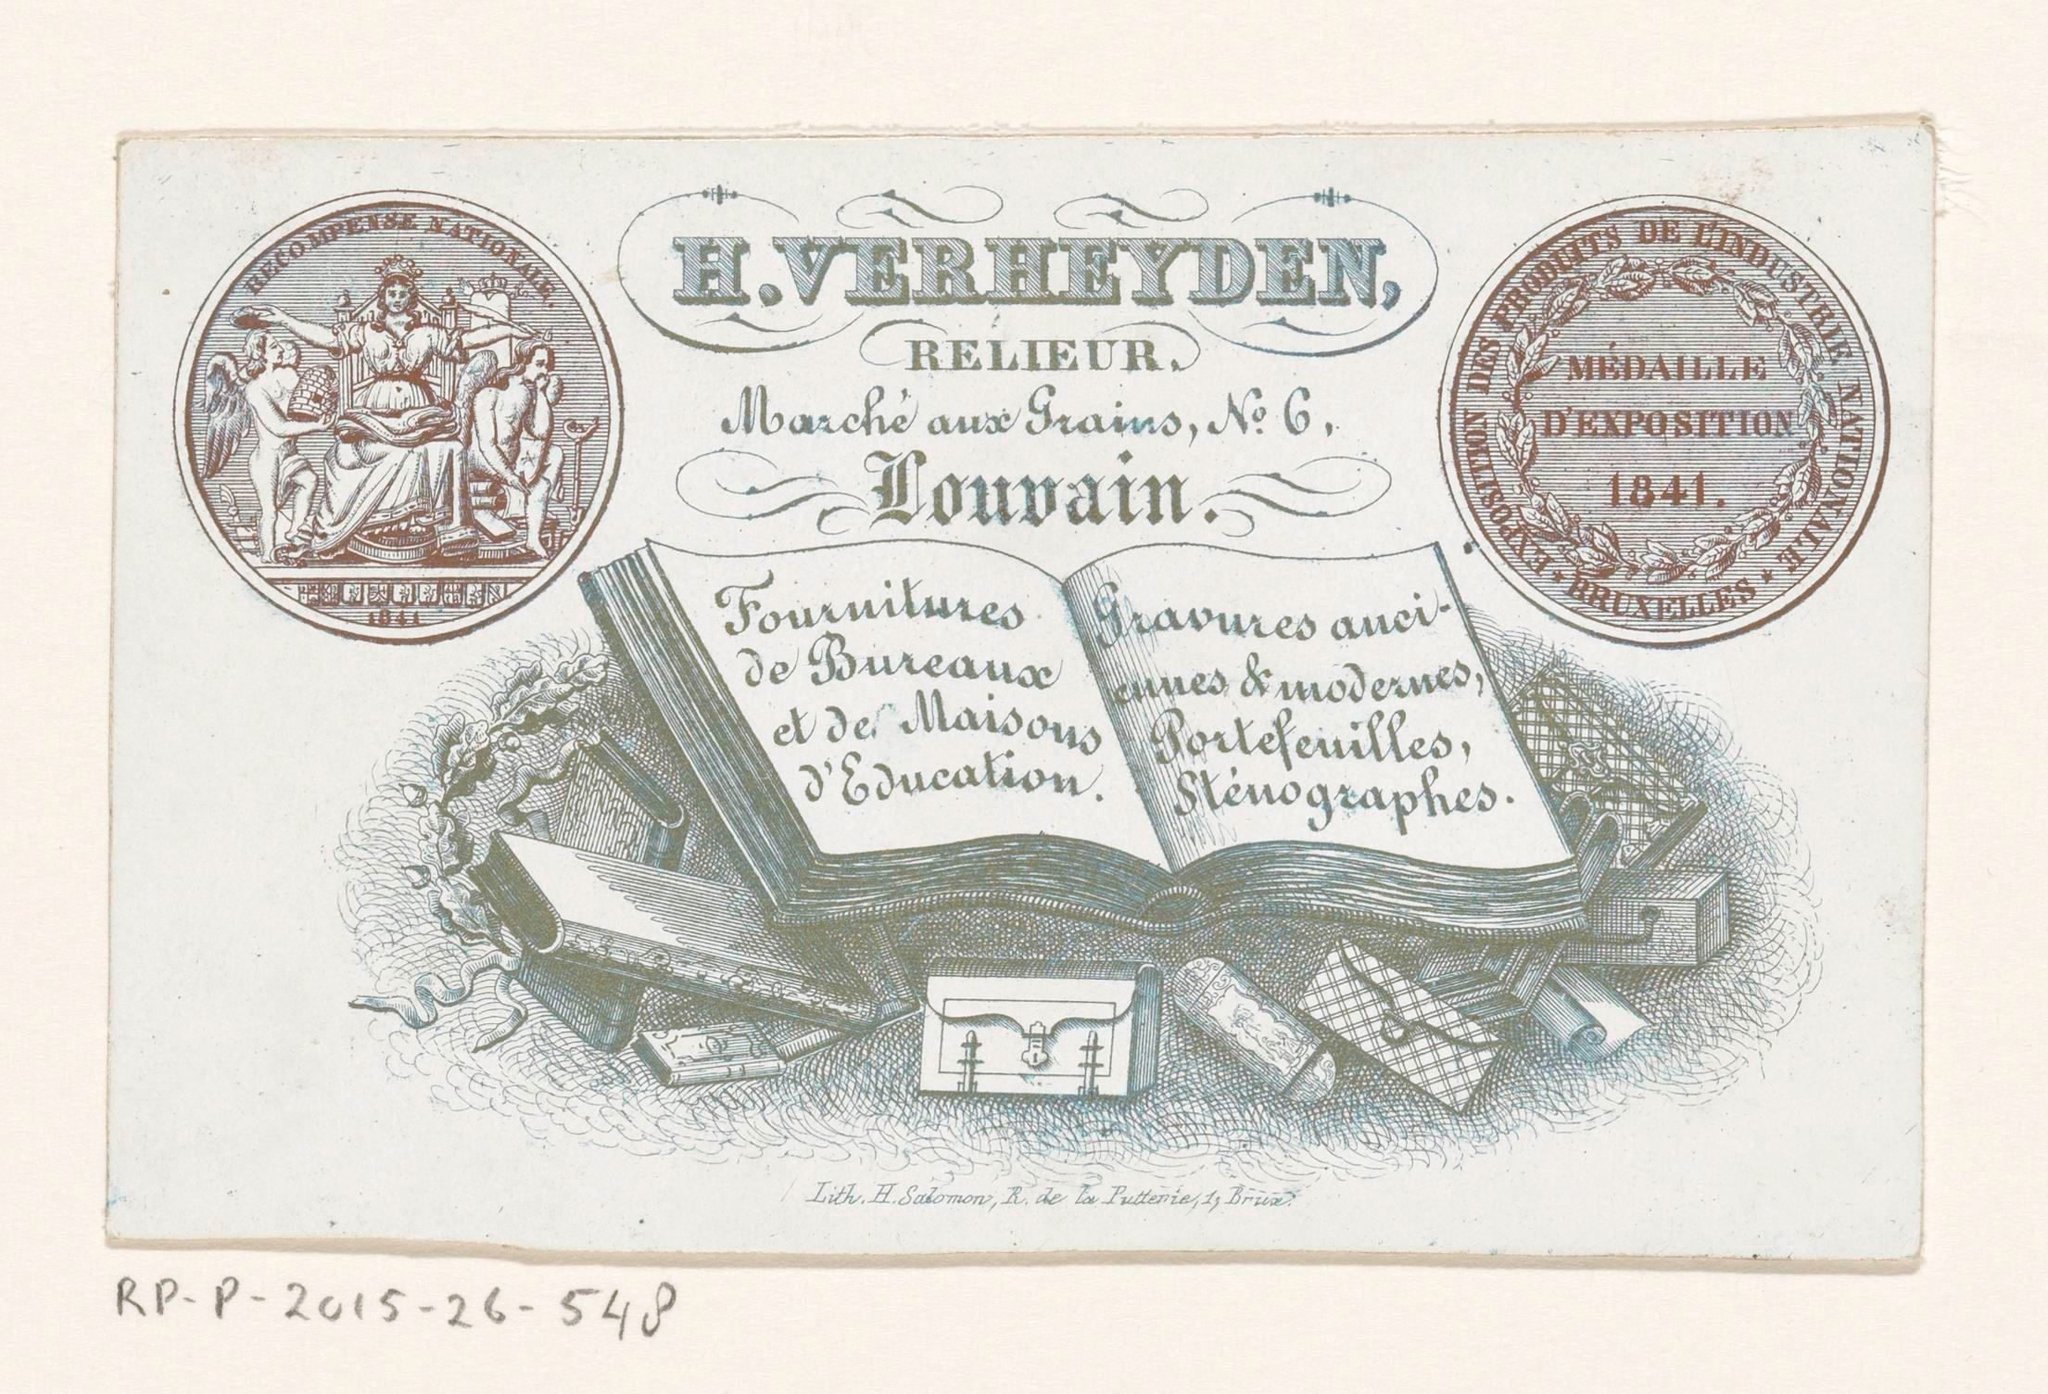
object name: print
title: Visitekaartje van boekbinder H. Verheyden te Leuven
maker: h. salomon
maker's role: printer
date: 1841-1865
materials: porcelainized cardboard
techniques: lithograph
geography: brussels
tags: personifications of countries, nations, states, districts, etc., memorial medal, book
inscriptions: collector's mark: Lugt 2228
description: Een opengeslagen boek omringd door kantoorartikelen. Aan de linkerzijde de voorkant van een medaille voorstellende de personificatie van België omringd door drie putti, aan de linkerzijde de achterkant van de medaille.